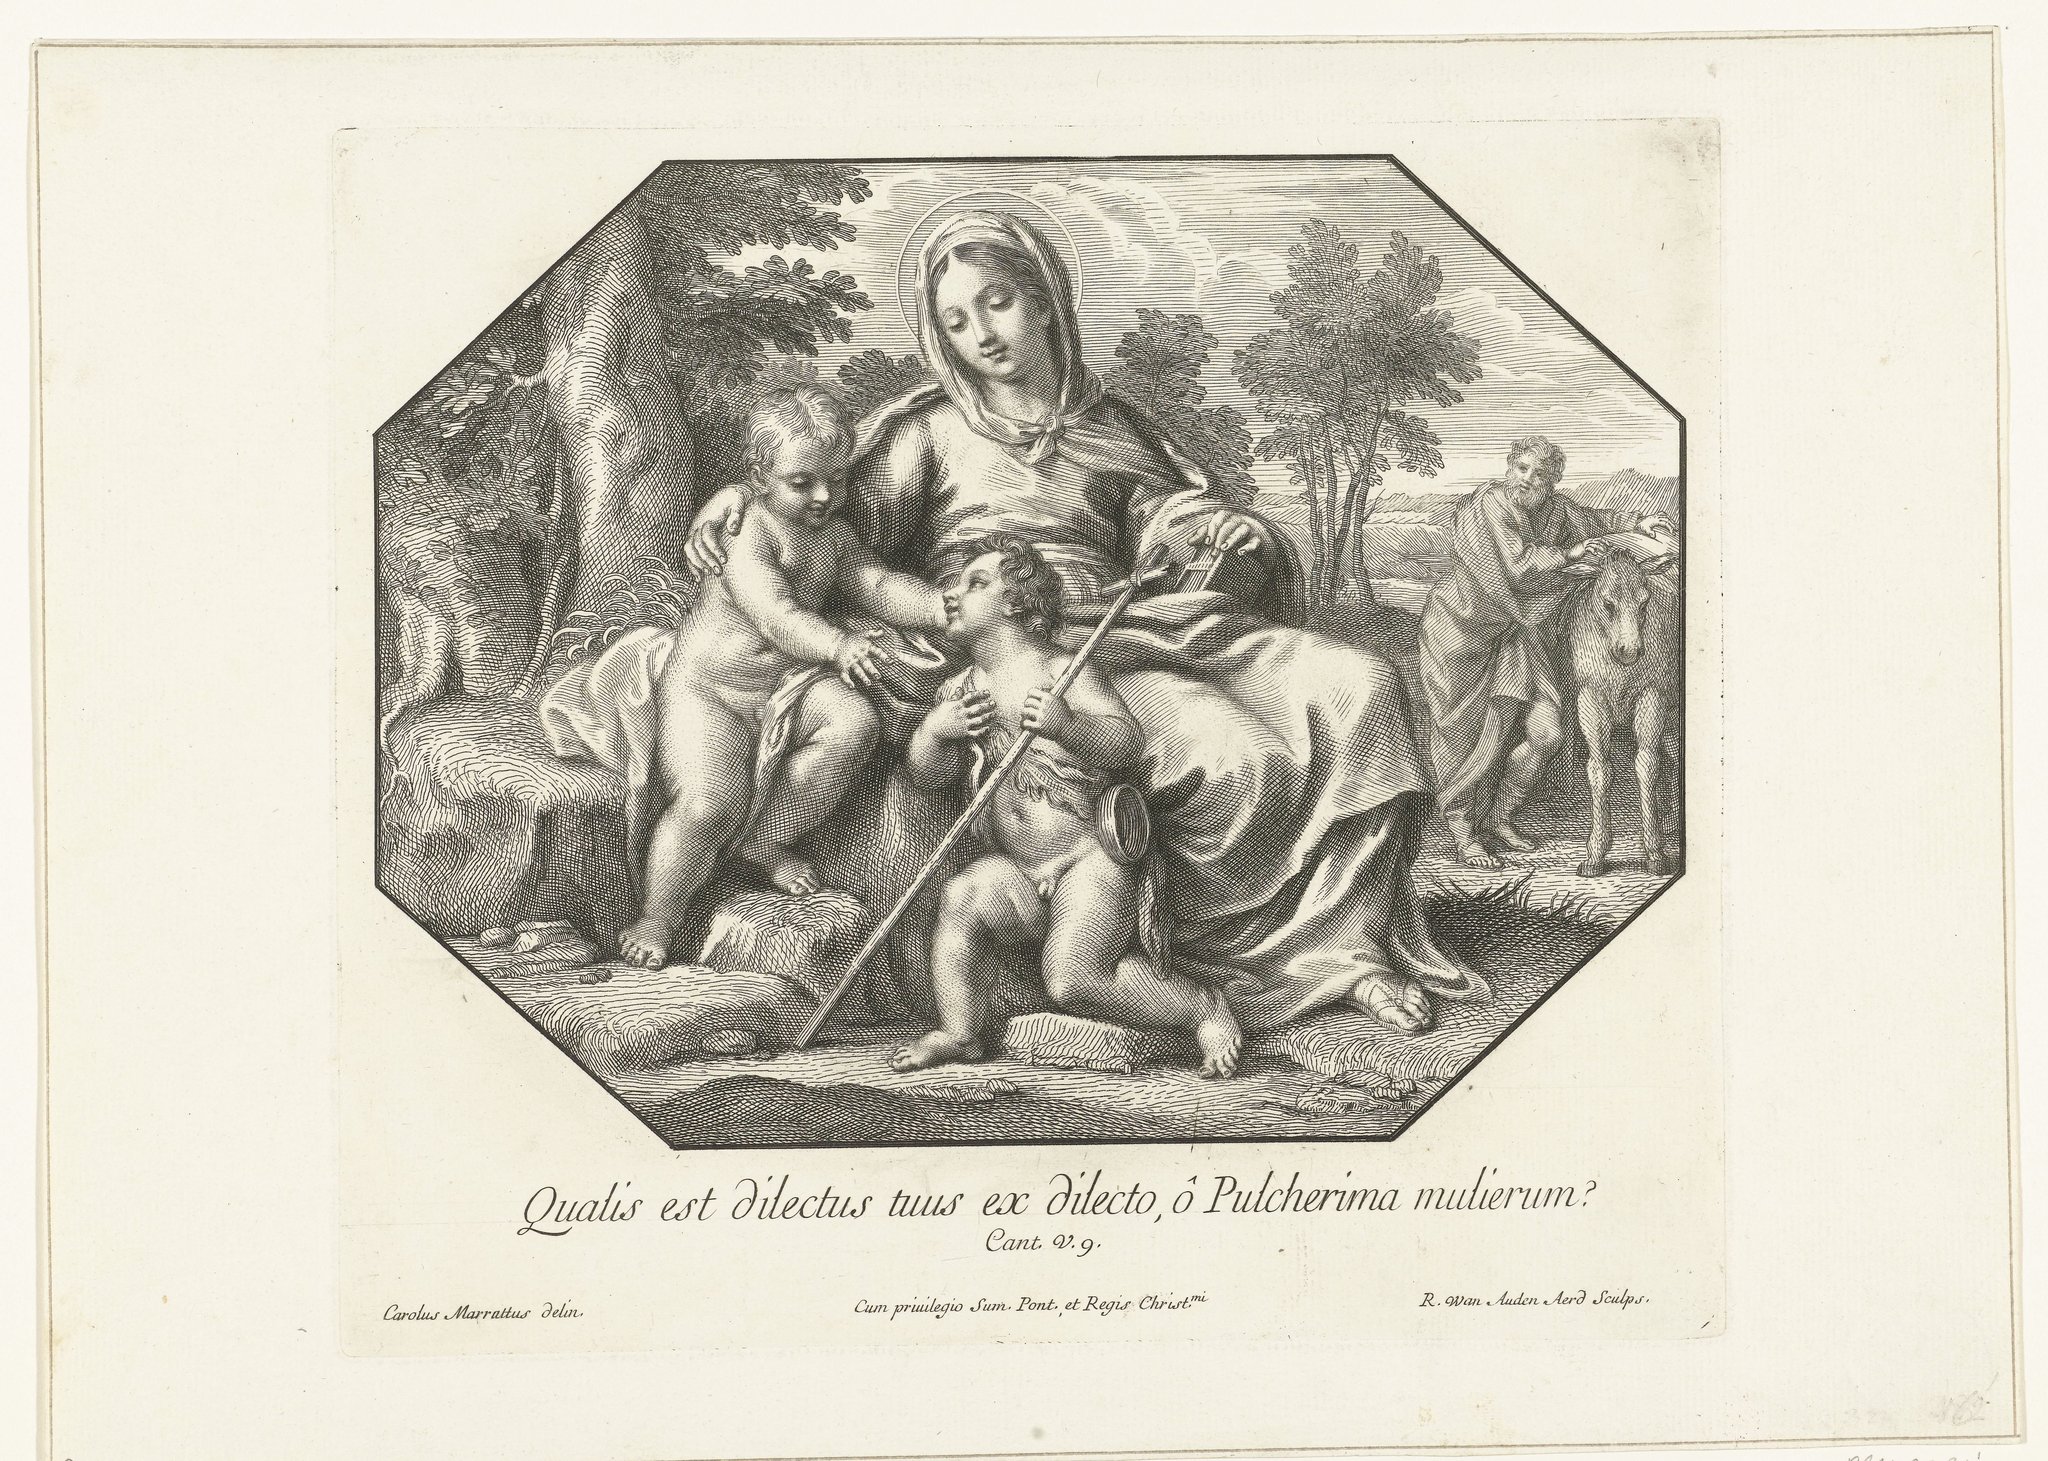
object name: print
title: Rest on the Flight into Egypt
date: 1685-1723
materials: paper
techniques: engraving, etching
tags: rest on the flight into egypt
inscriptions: collector's mark: Lugt 240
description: Maria zit met Christus en Johannes de Doper onder een boom te rusten. Johannes houdt een houten kruis in zijn hand. Op de achtergrond staat Jozef bij de ezel. Onder de voorstelling een vers in het Latijn.